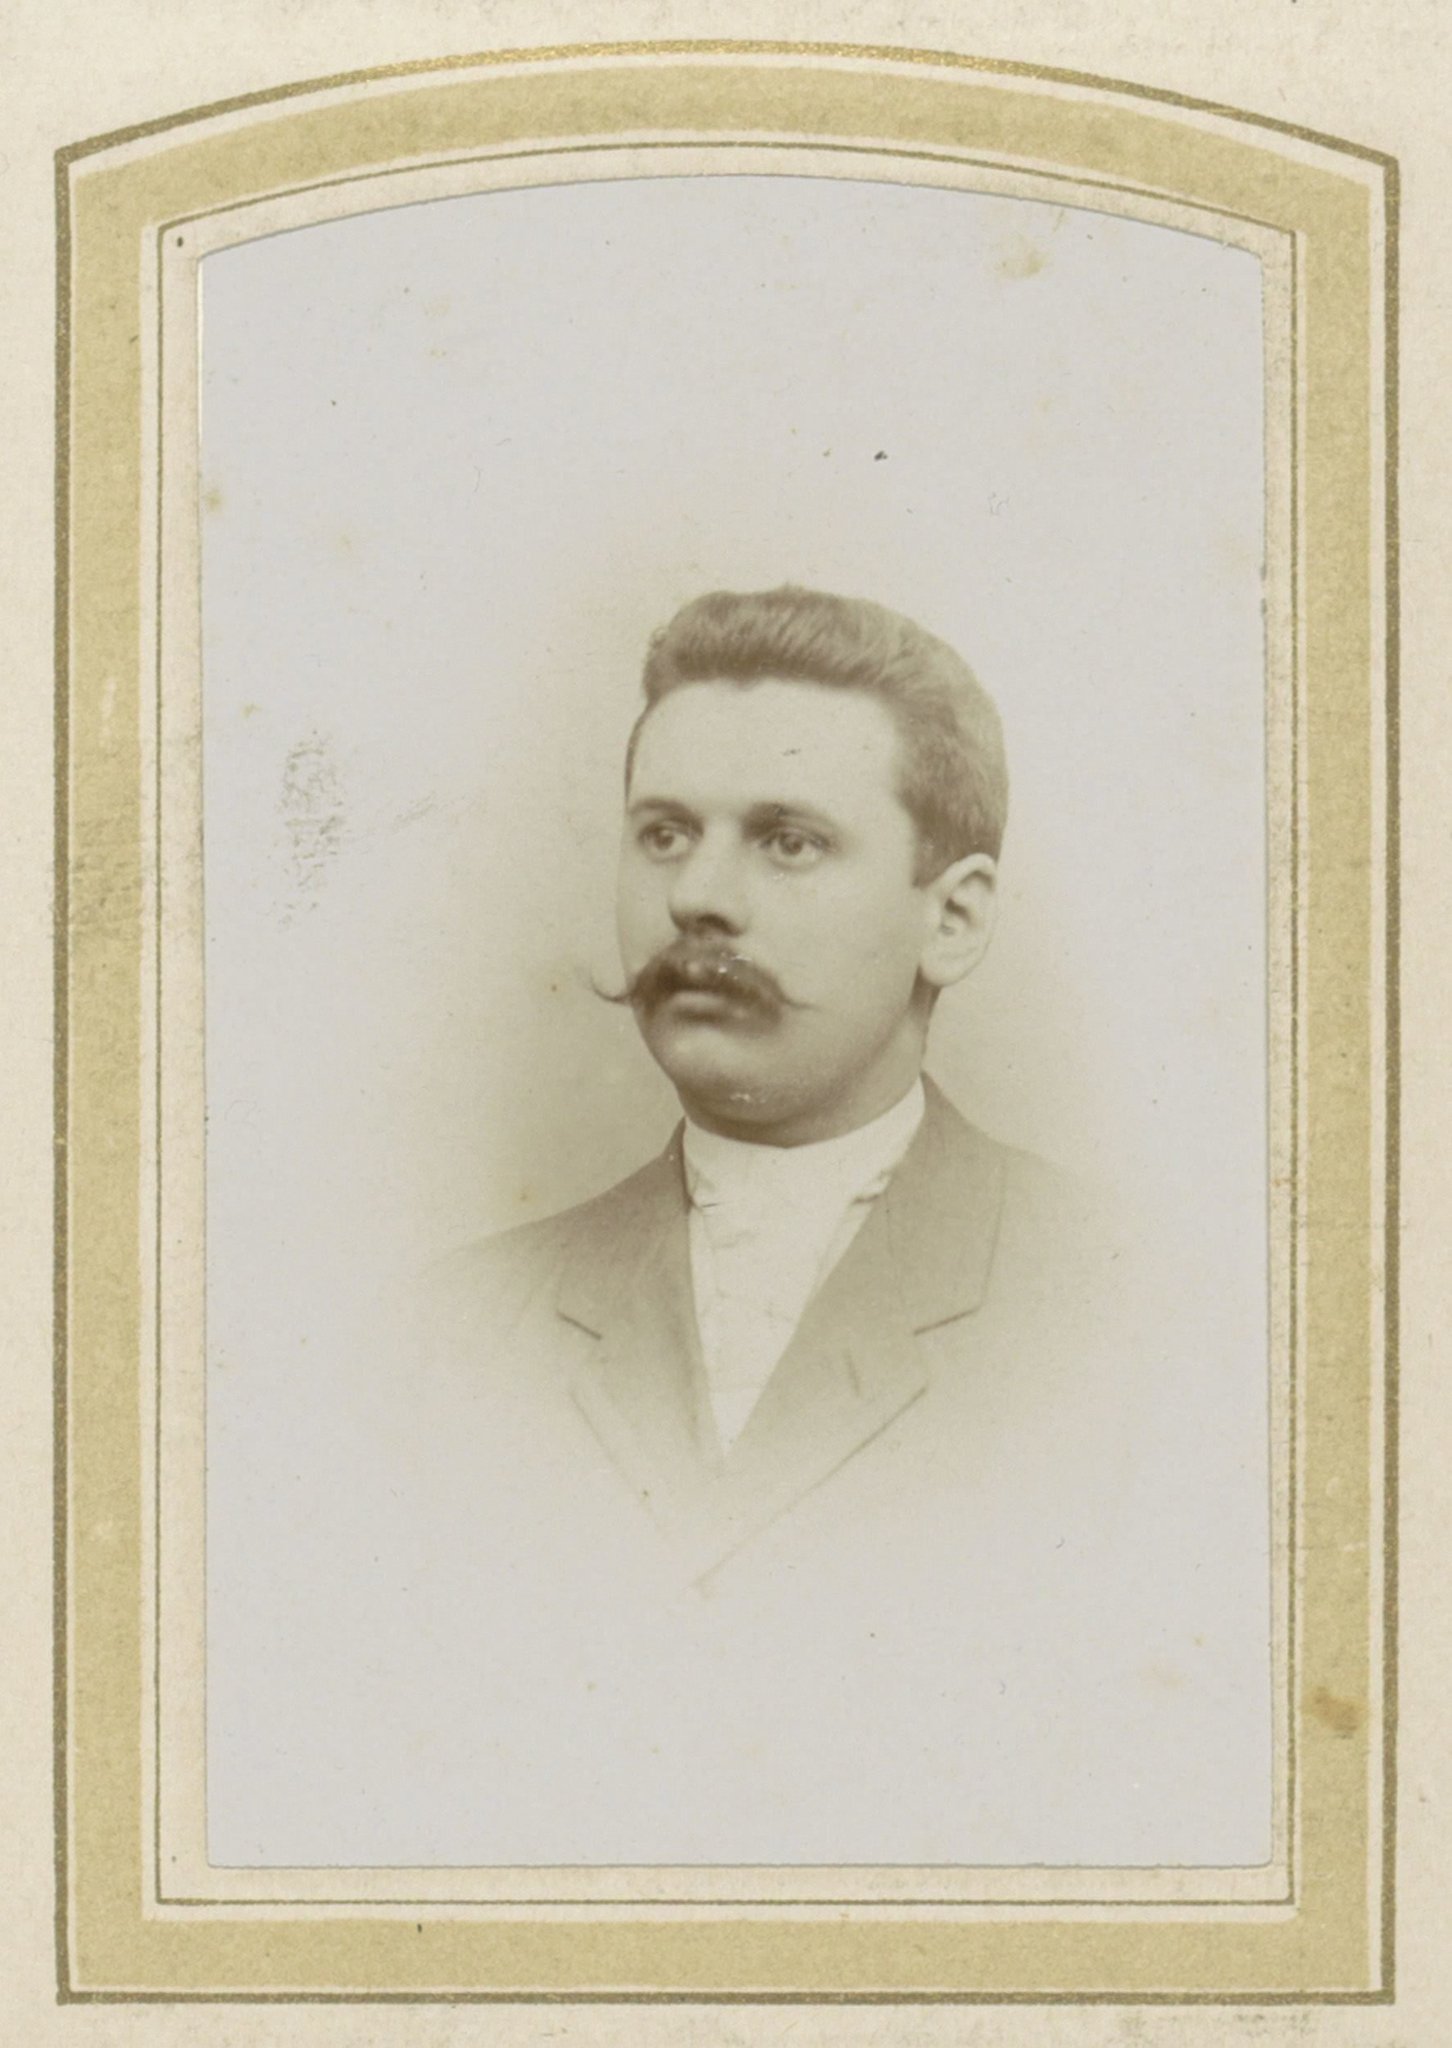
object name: carte de visite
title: Portret van een man met een snor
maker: emma kirchner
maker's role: fotograaf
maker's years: 1830-1909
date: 1863-1899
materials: cardboard, paper, photographic support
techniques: collodion silver print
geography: delft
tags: moustache, historical persons, neck-gear ~ clothing, clothing for the upper part of the body, delft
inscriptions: address: ‘Delft Zuiderstraat 164’, address: ‘Arnhem’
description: Onderdeel van Fotoalbum van een Nederlandse familie met 168 cartes-de-visite en kabinetfoto's.